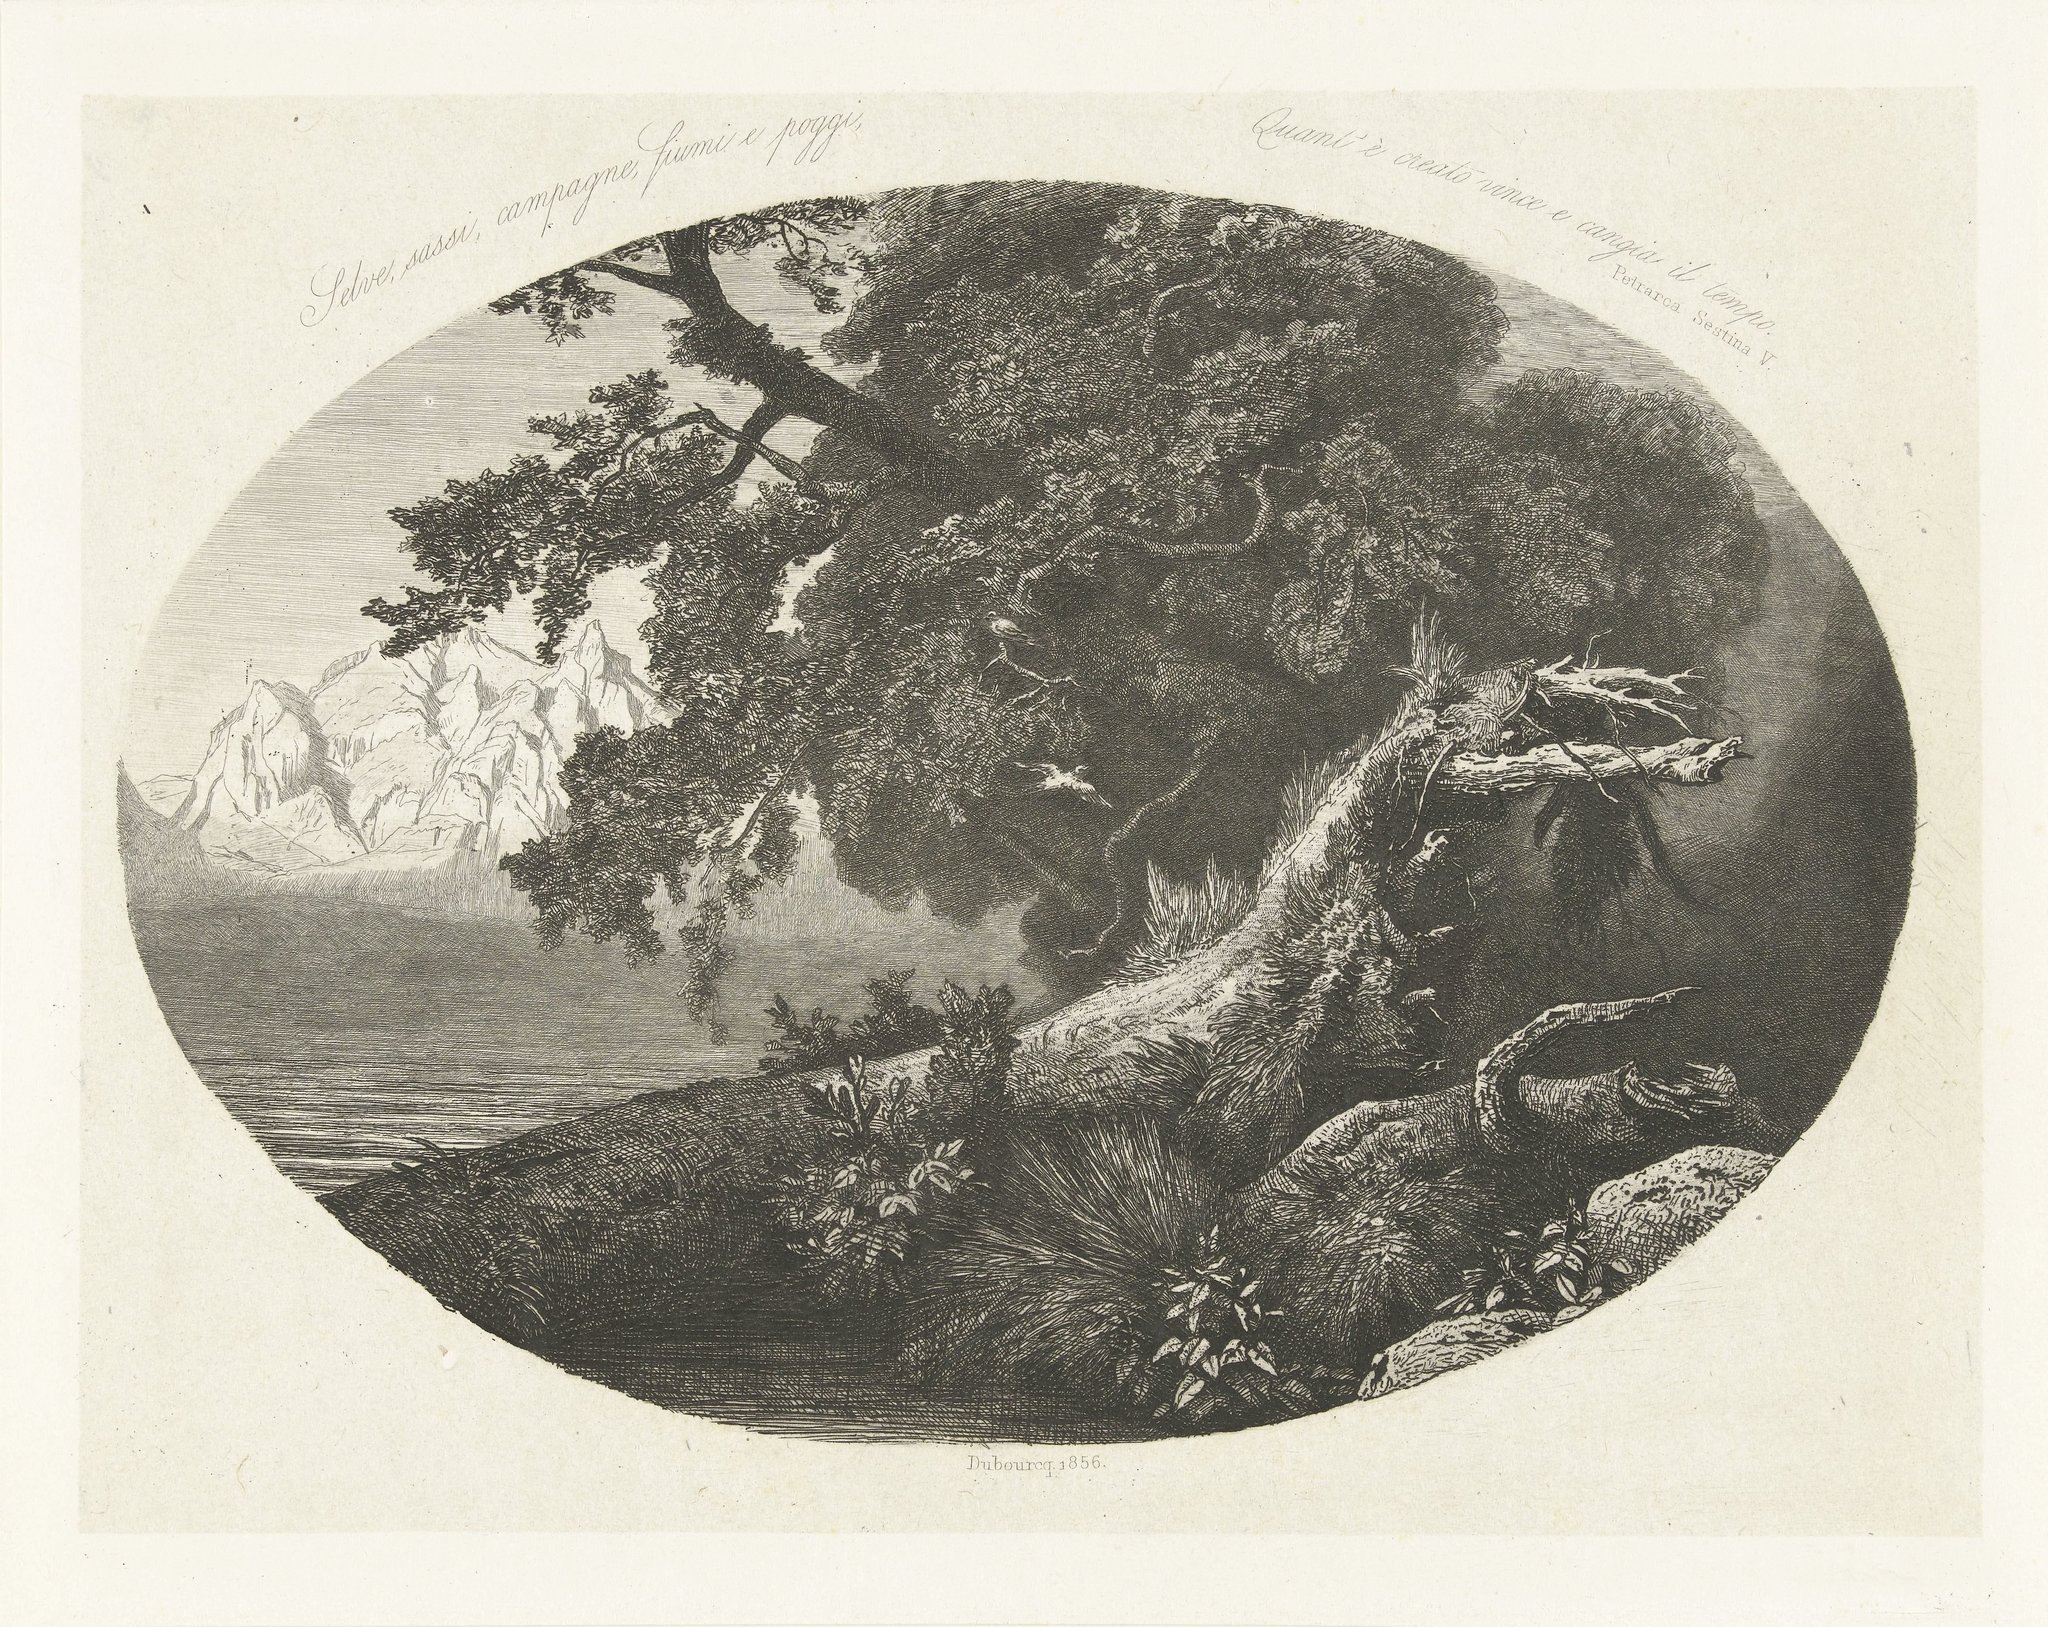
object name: print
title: Ontwortelde boomstam aan de kust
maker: pierre louis dubourcq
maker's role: draughtsman, painter, print maker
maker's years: 1815-1873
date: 1856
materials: paper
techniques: drypoint, etching, roulette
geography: netherlands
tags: groups of trees, mountain-range, snow peaks, coast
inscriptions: collector's mark: Lugt 2228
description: Aan de kust van een meer ligt een ontwortelde boomstam. Aan de overkant zijn sneeuwbedekte bergtoppen te zien. Om de afbeelding heen een vers van Petrarca over de vergankelijkheid van de natuur in het Italiaans.